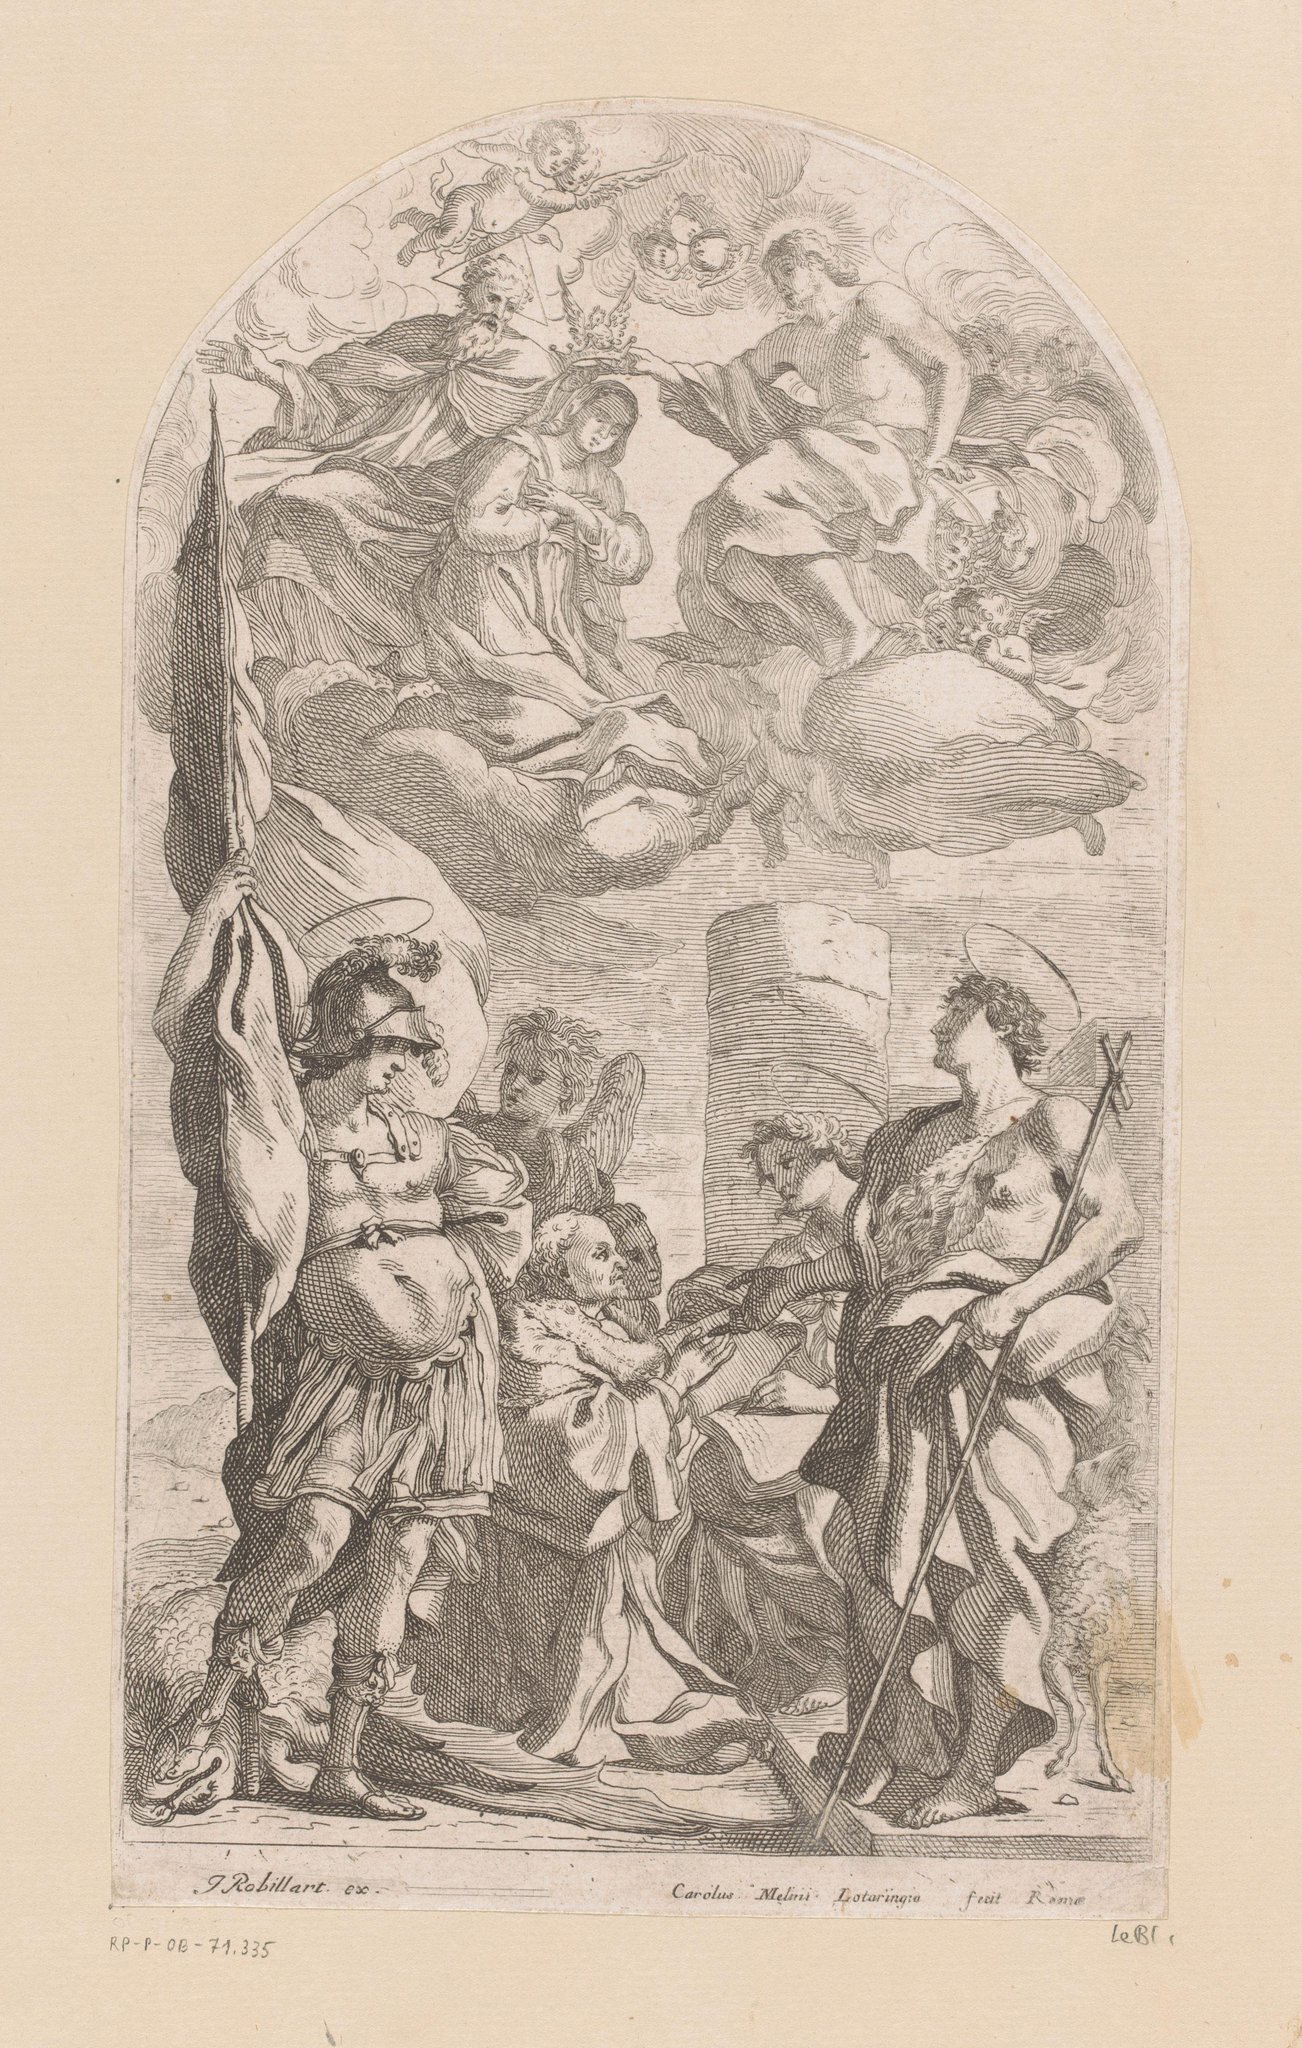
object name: print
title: Kroning van Maria met Johannes de Doper en H. Florian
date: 1622-1649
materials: paper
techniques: engraving, etching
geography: rome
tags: coronation of mary in heaven (usually the holy trinity present), the soldier martyr florian of lorch; possible attributes: bucket (pitcher), lance with banner, millstone, palm-branch, shield (with cross), sword, series of scenes from the life of john the baptist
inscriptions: collector's mark: Lugt 240